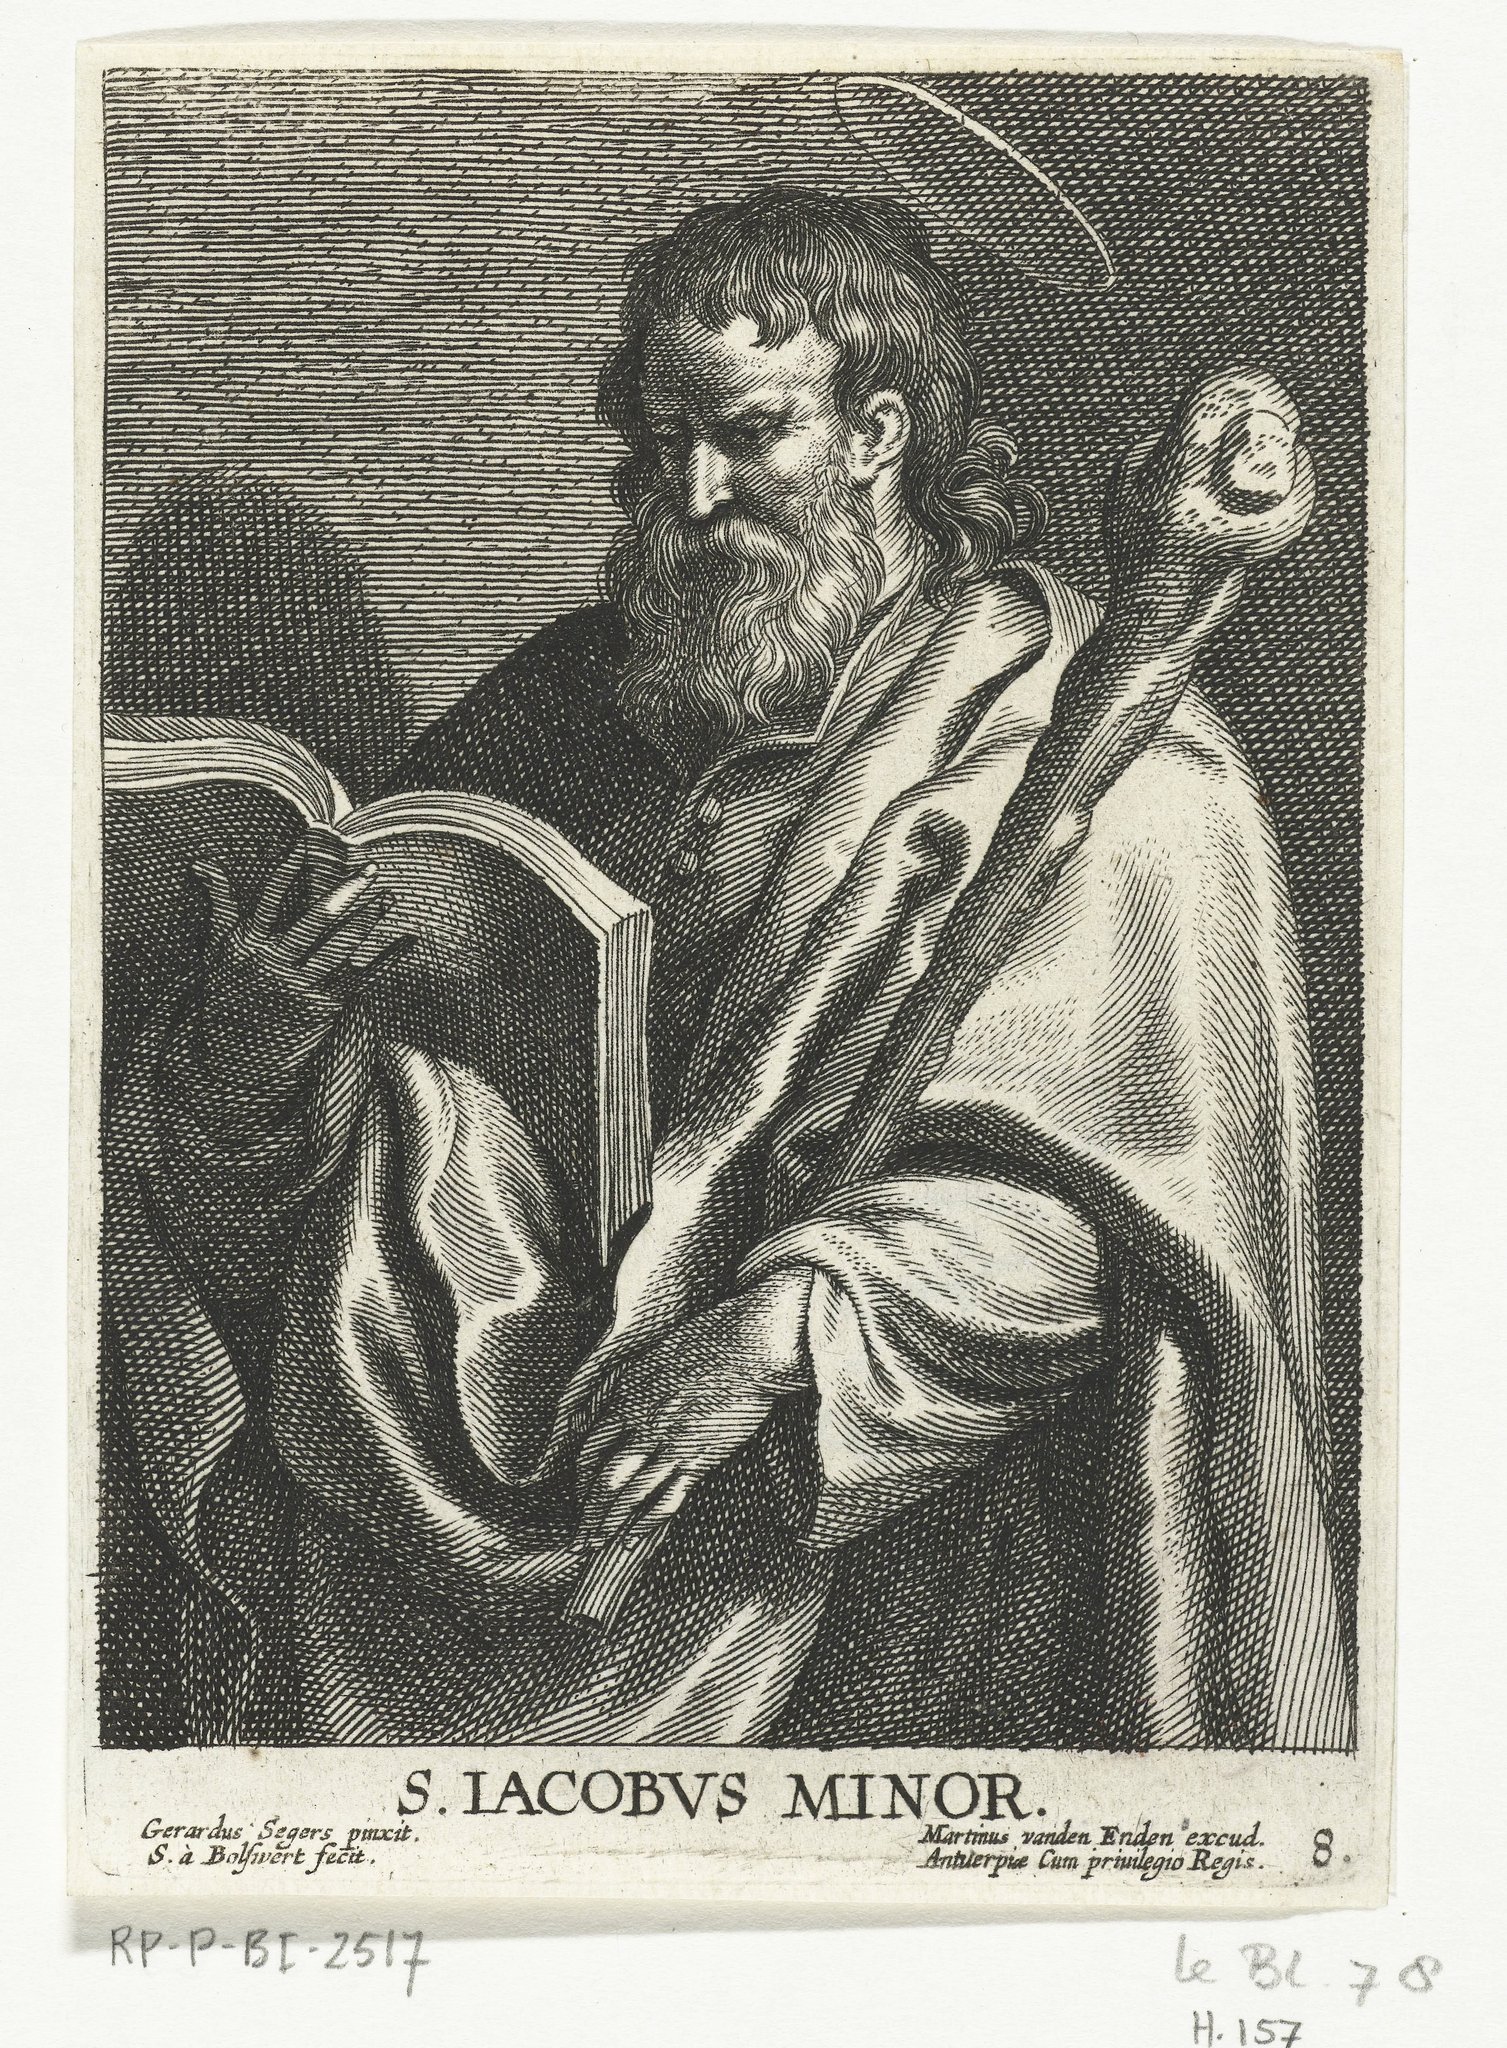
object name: print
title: Heilige Jakobus de Mindere met knots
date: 1596-1659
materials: paper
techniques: engraving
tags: the apostle james the less, first bishop of jerusalem; possible attributes: book, fuller's club, scroll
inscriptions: collector's mark: Lugt 240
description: Prent uit serie met veertien prenten met Christus, Paulus en twaalf apostelen naar ontwerp van Gerard Seghers.